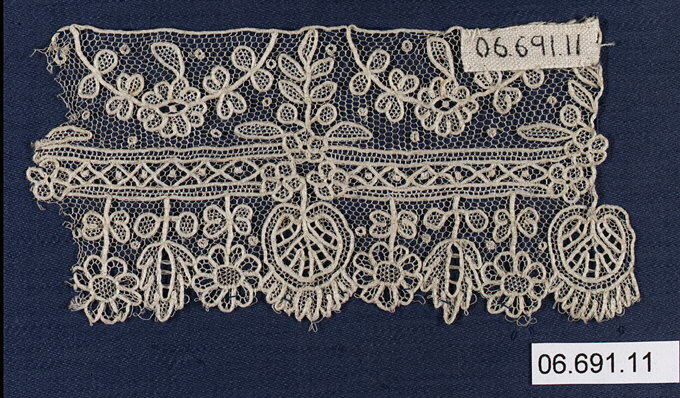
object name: sample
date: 1801-1900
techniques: lace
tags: flowers,leaves